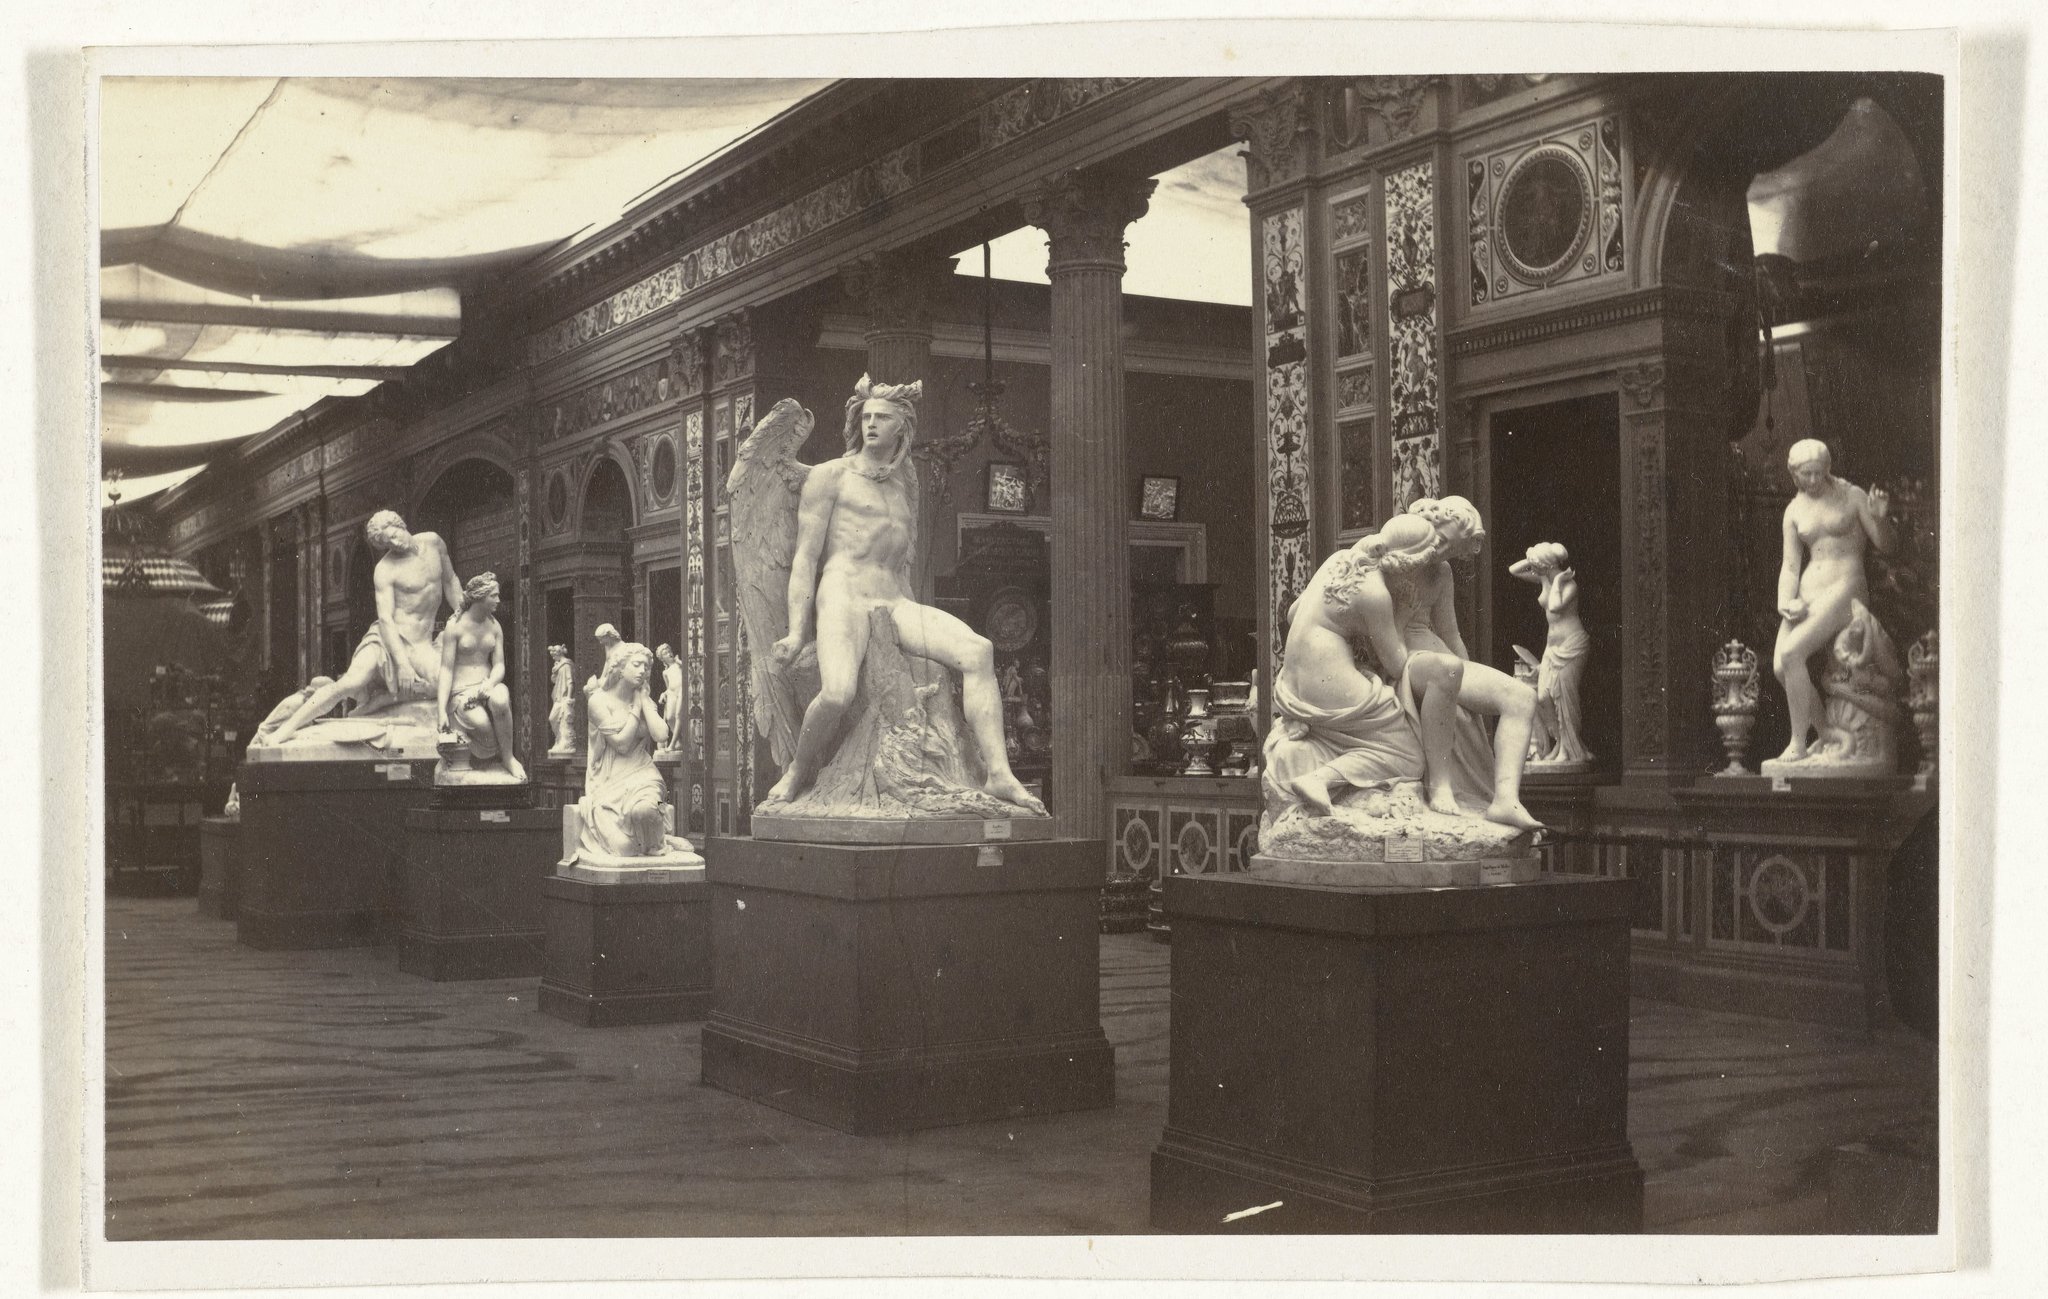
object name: photograph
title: Galerie Italienne op de Wereldtentoonstelling van 1867 in Parijs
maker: pierre petit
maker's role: fotograaf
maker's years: 1832-1909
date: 1867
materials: cardboard, paper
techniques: albumen print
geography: paris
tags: gallery of sculptures, world fair, world exhibition, paris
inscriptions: inscription: ‘Expo 1867/ Galerie Italienne/ 120€’